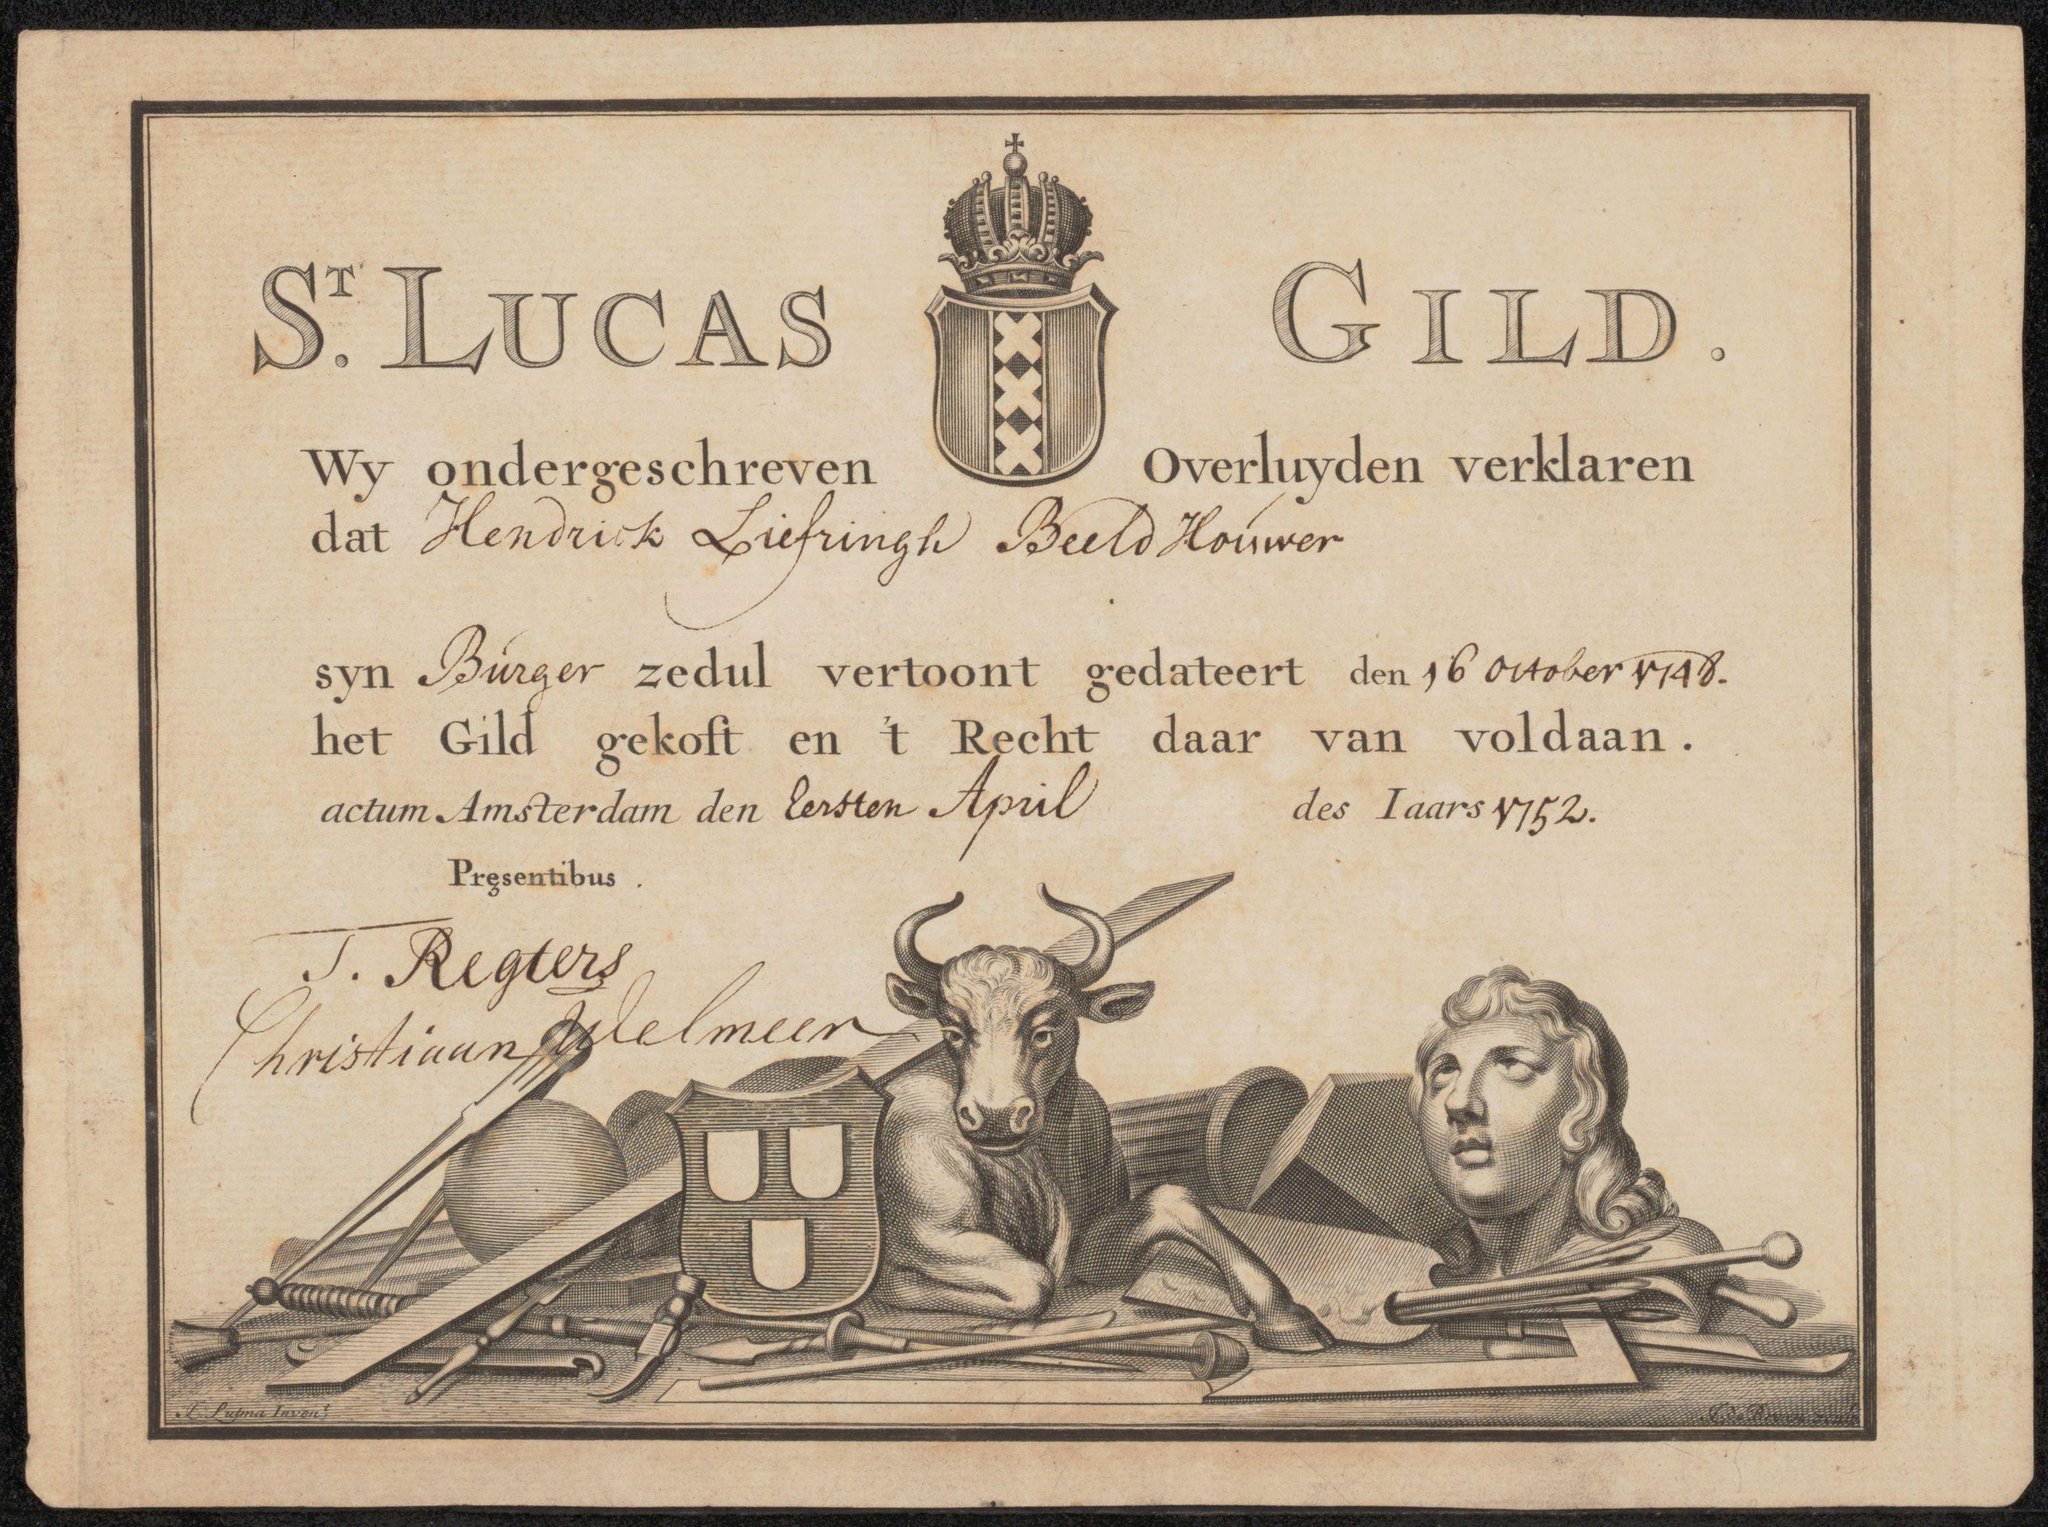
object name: print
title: Gildebrief van Hendrick Liefringh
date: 1752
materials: ink, paper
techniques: pen, printing, writing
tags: coat of arms of guild of st. luke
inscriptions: collector's mark: Lugt 2228, collector's mark: Lugt 2233